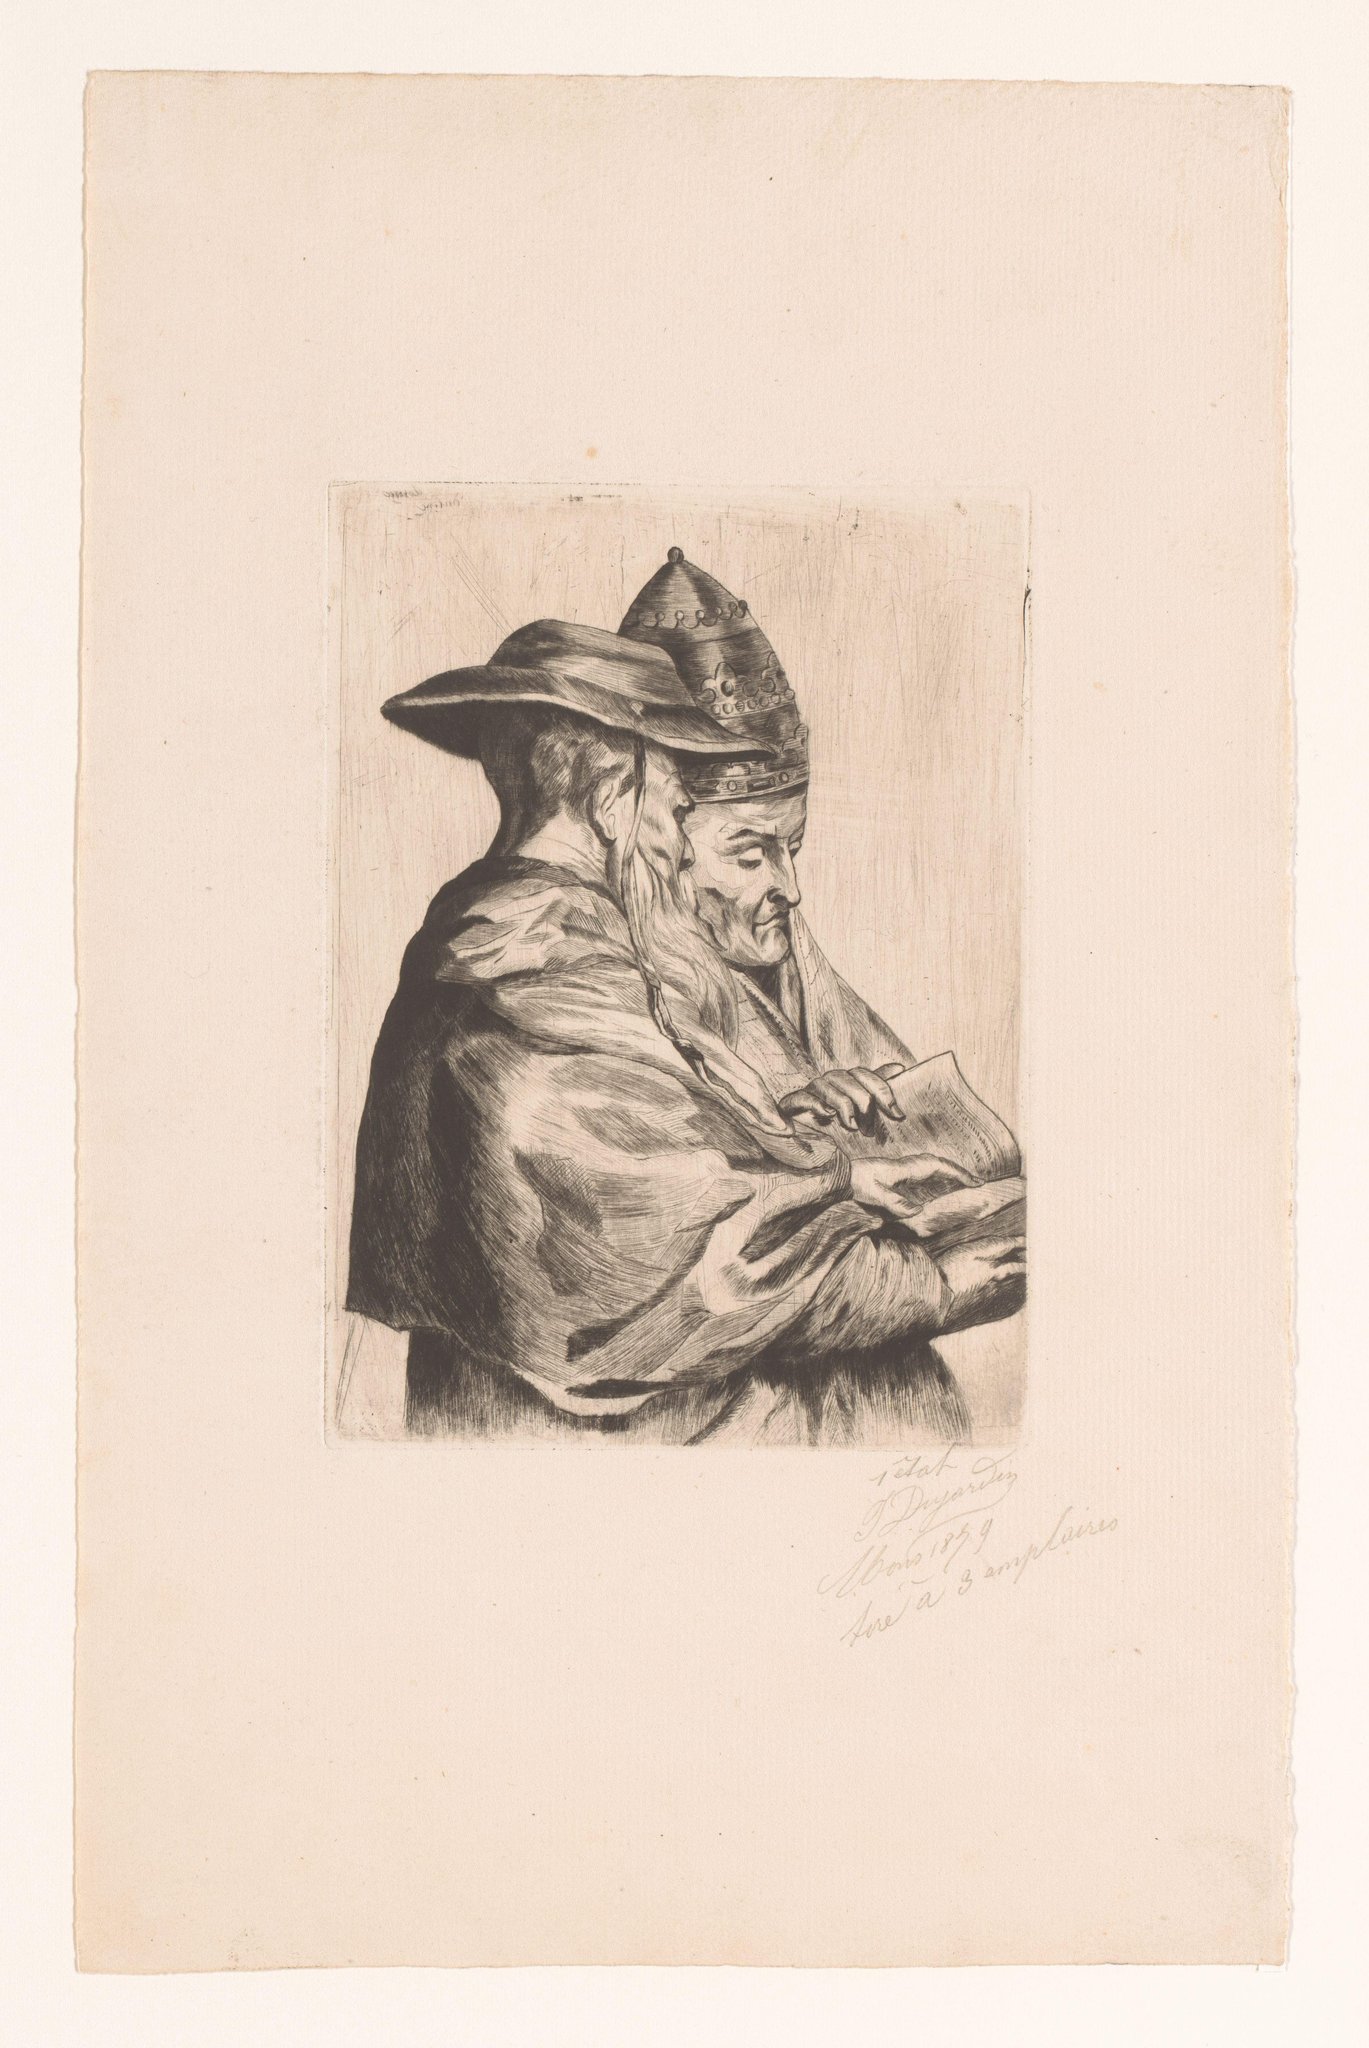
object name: print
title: Kardinaal en bisschop bestuderen een boek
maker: joseph dujardin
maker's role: print maker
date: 1879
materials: paper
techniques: drypoint, etching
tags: archbishop, bishop, etc. (roman catholic), cardinal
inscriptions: collector's mark: Lugt 2228, inscription: ‘1 etat; Tire a 3 emplaires’